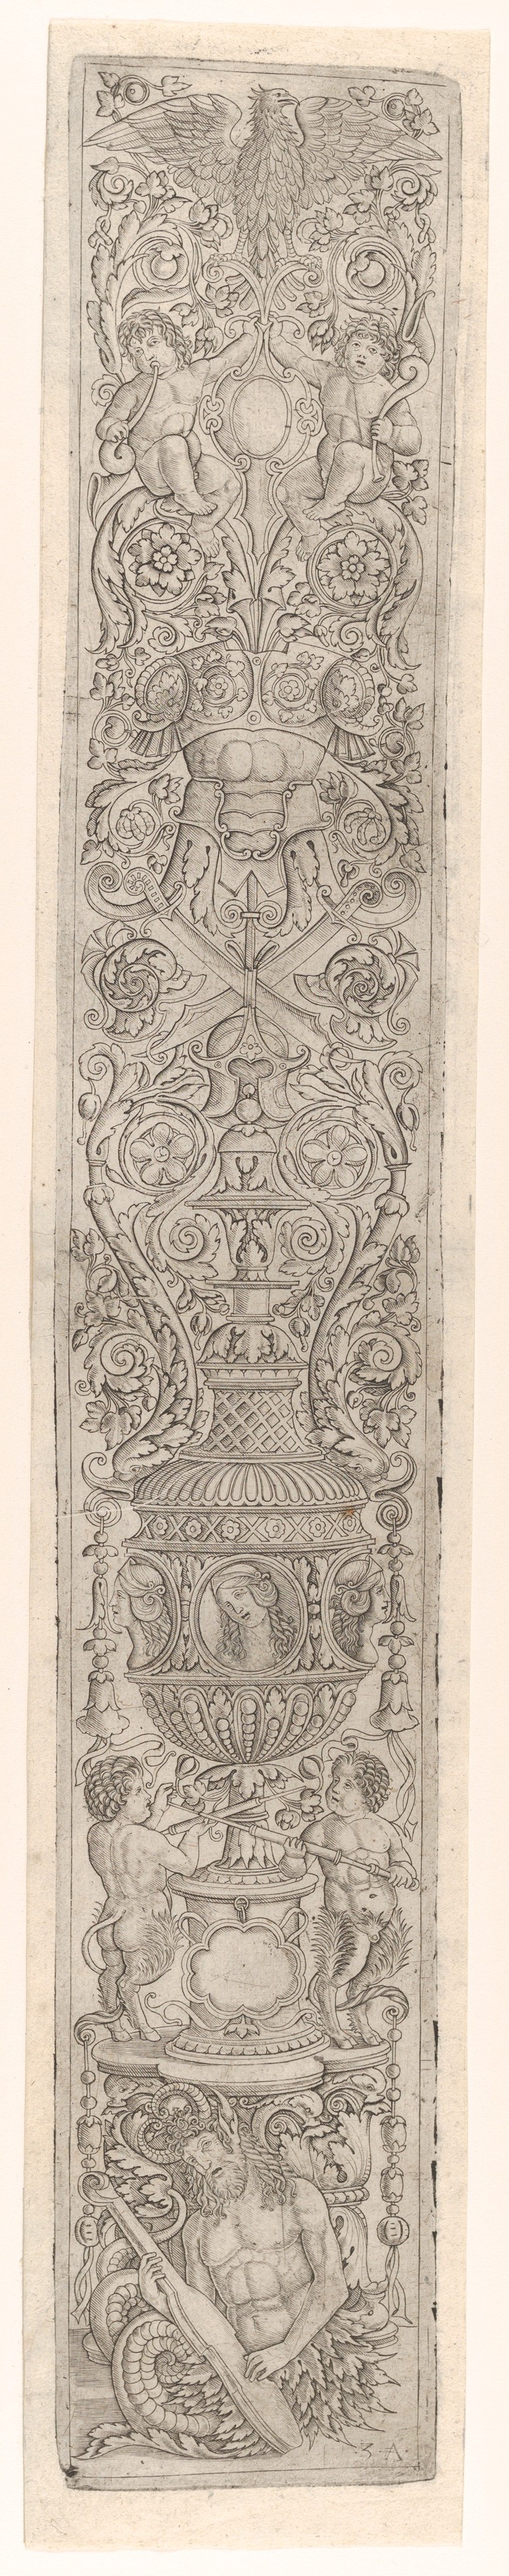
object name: print ornament architecture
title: A Triton and Two Infant Satyrs, from Twelve Ornamental Panels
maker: giovanni antonio da brescia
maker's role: artist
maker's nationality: italian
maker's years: 1490-1525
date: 1490-1515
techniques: engraving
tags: triton,satyrs